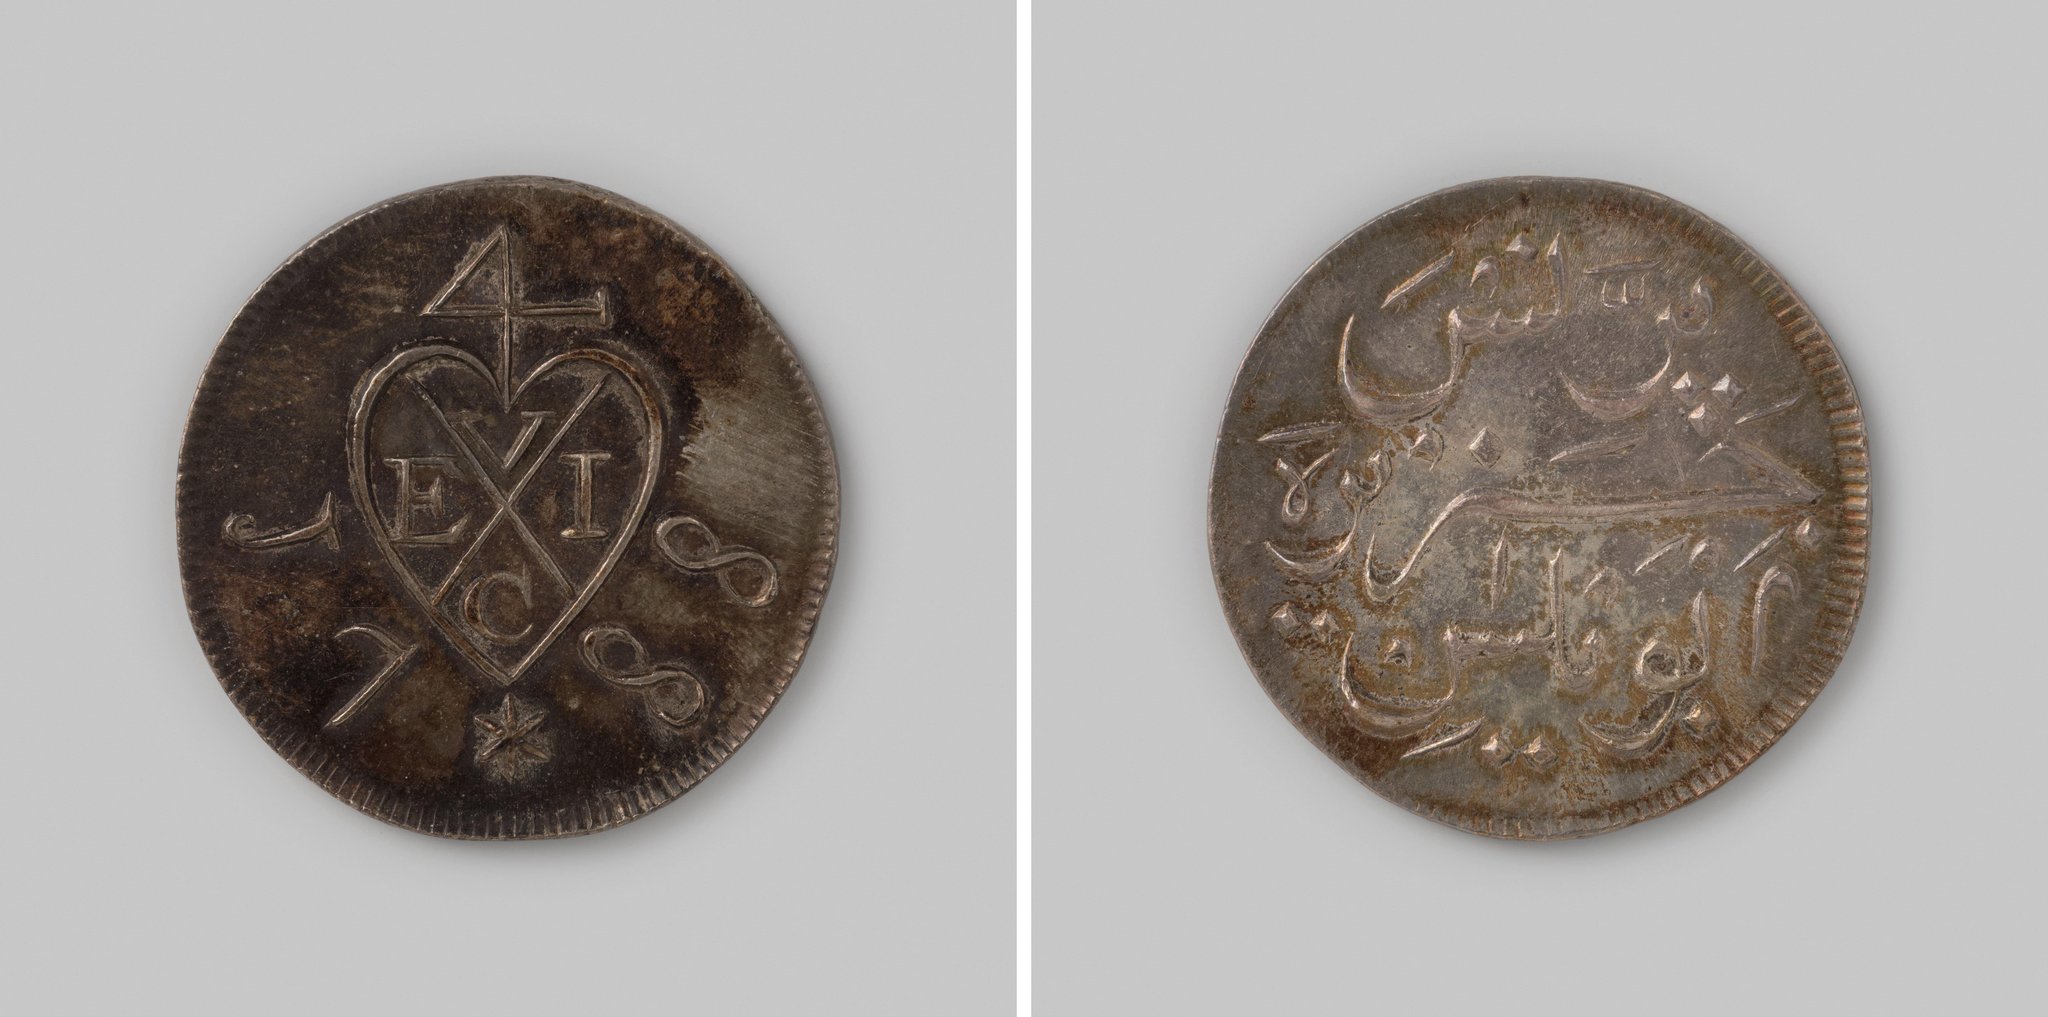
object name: coin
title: Malakka, Prince of Wales Island of Pulu Penang, ½ dollar, 1788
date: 1788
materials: silver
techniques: striking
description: Zilveren munt. Voorzijde: hartvormig merk van de Engelse Oostindische Compagnie (EIC), waaronder ster. Jaartal ter weerzijden van het merk. Keerzijde: drieregelig opschrift in Arabische lettertekens: jezirah prins abwails. Gladde rand.